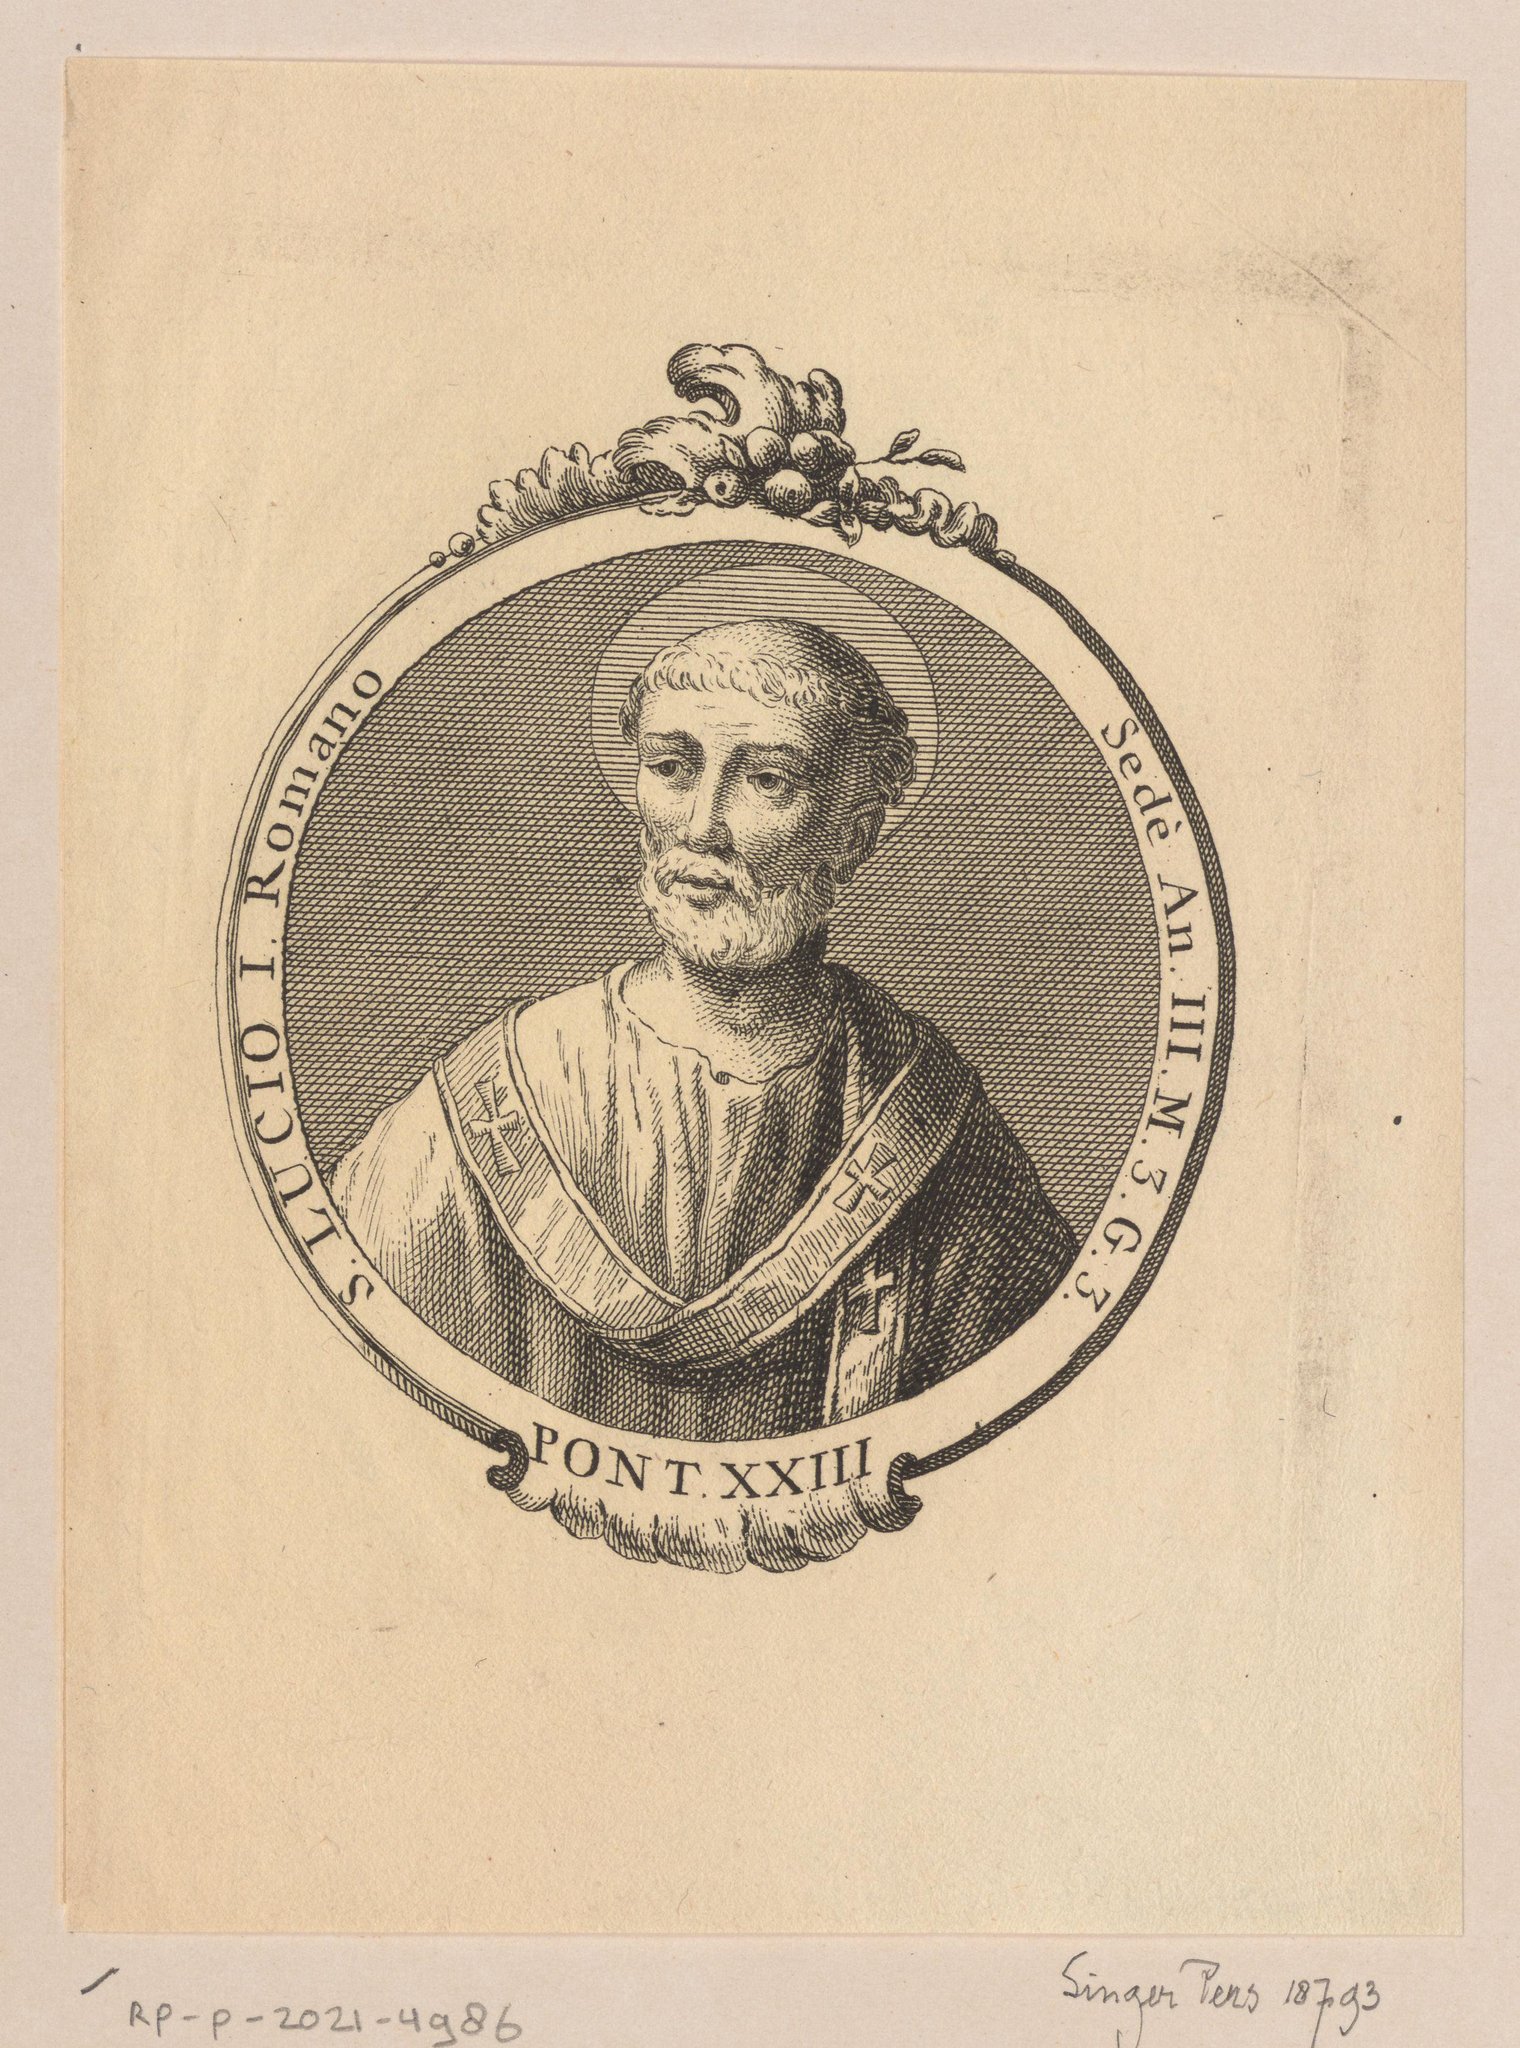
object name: print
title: Portret van paus Lucius I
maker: Anonymous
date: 1775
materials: paper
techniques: etching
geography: italy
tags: rome, nimbus, halo ~ radiance emanating from persons or things, rocaille ornament, historical persons, pope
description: Prent waarschijnlijk uit: Effigies Romanorum pontificum a S. Petro ad Pium VI (...). 2 dln. Venetië en Bassano del Grappa: Giuseppe Remondini, 1775. Prent met tekst in boekdruk op verso eerder gebruikt in: Platina (Bartholomaeus Sacchi). Storia delle vite dei pontefici da Platina e d'altri autori (...). 5 dln. Venetië: Domenico Ferrarin, 1760, dl. 1.